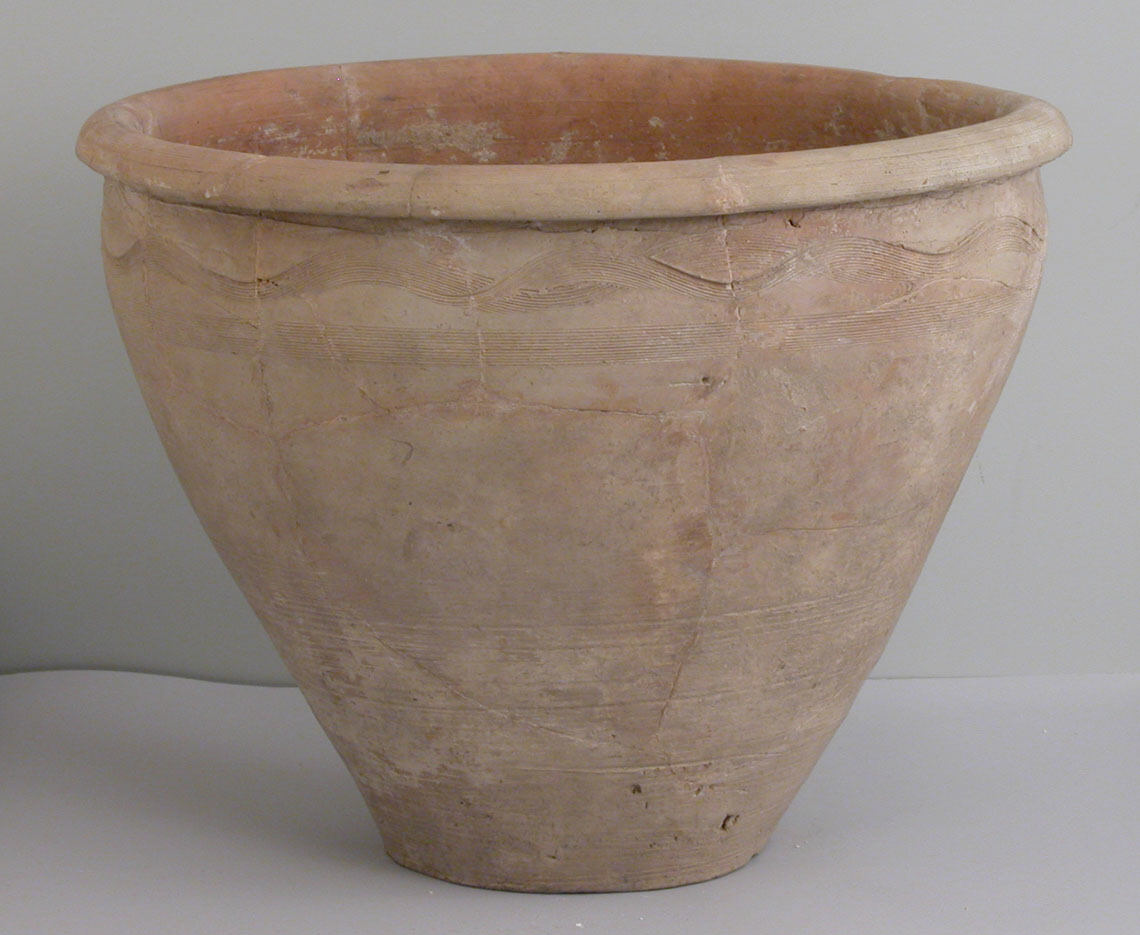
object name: bowl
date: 901-1000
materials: earthenware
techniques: incising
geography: iran